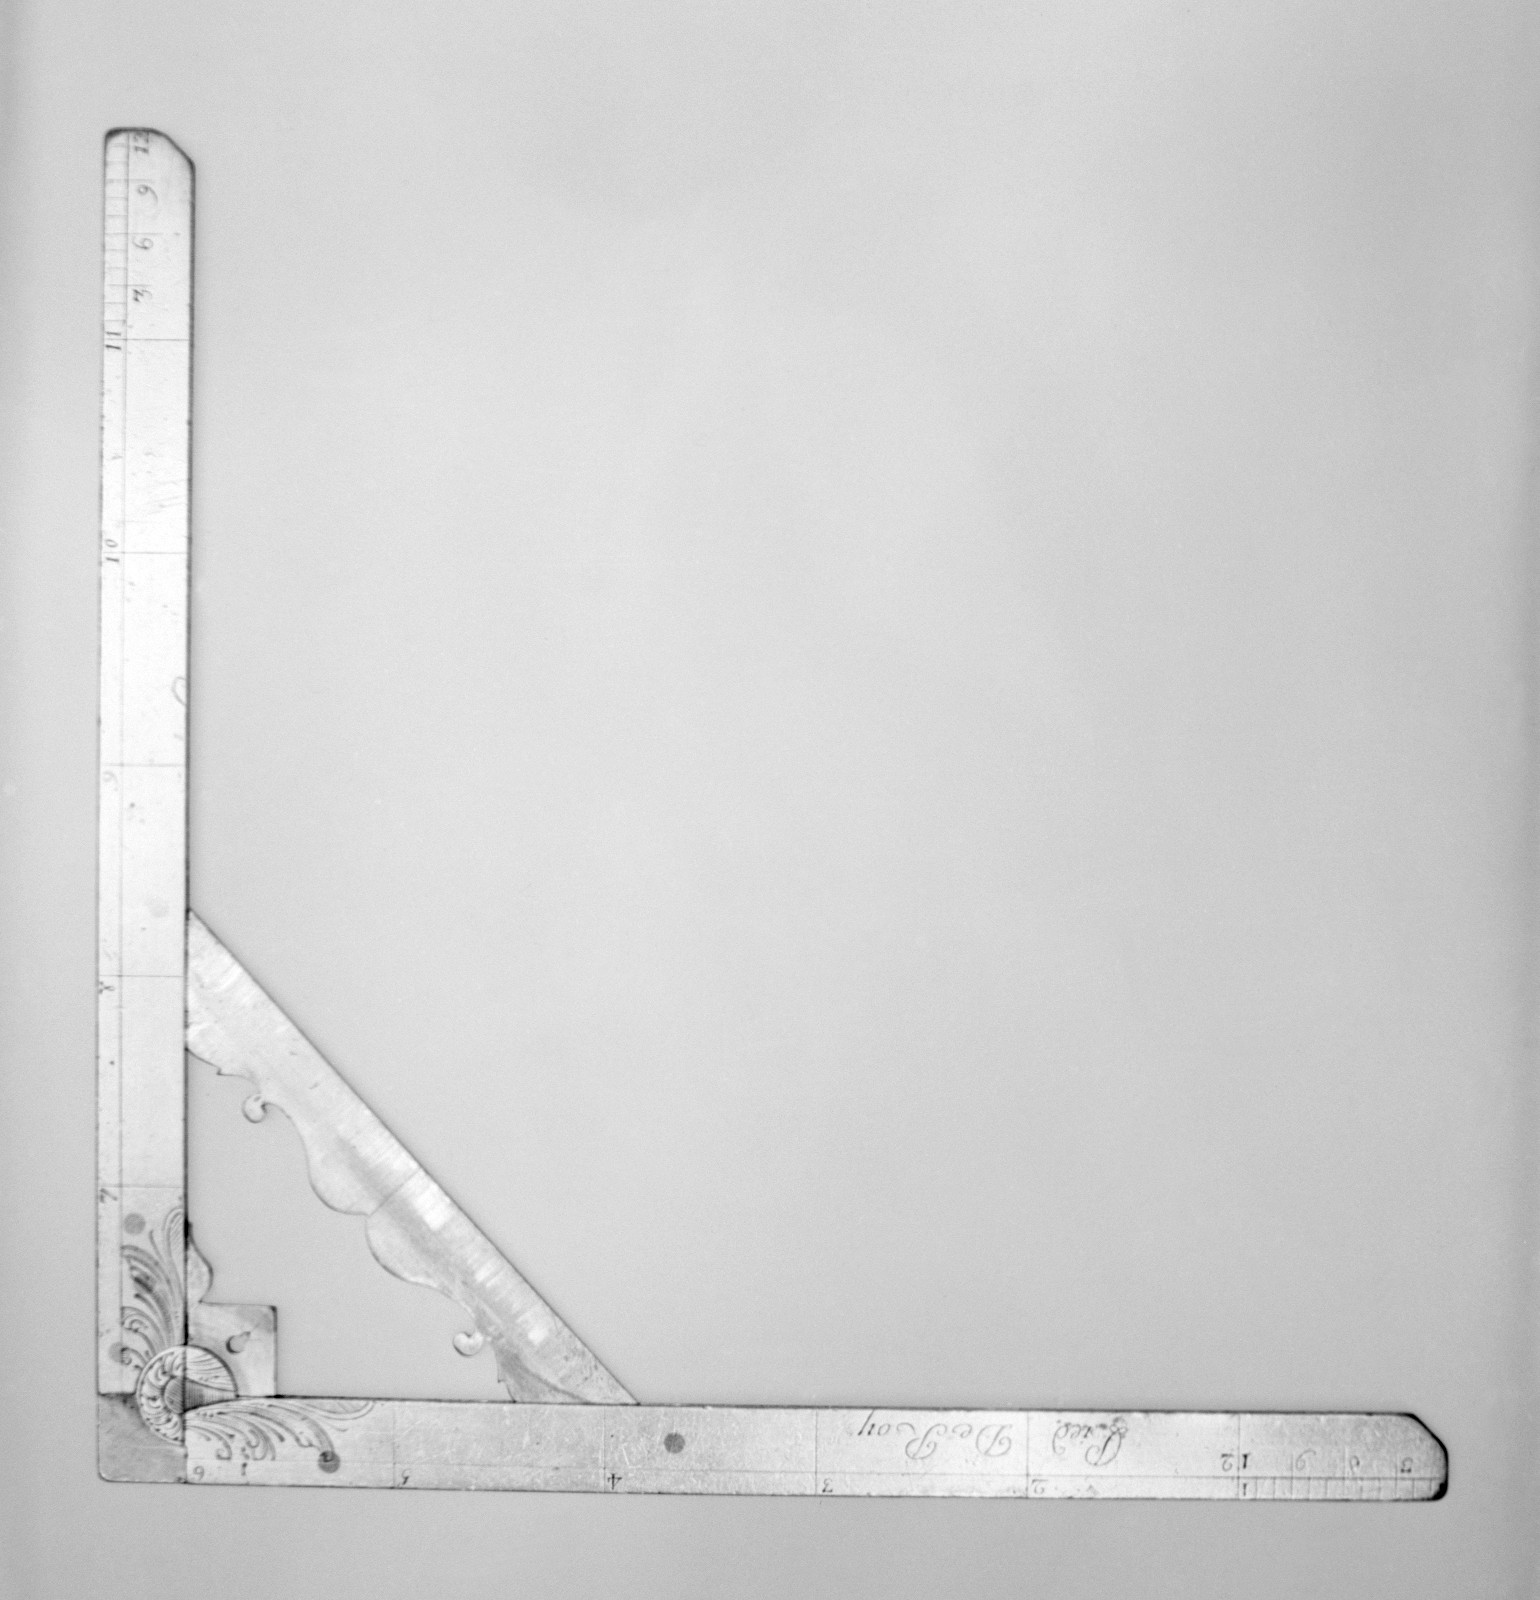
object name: foot rule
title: Foot-rule, square and level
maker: jacques baradelle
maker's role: maker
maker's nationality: french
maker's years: 1694-1794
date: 1751-1775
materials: brass